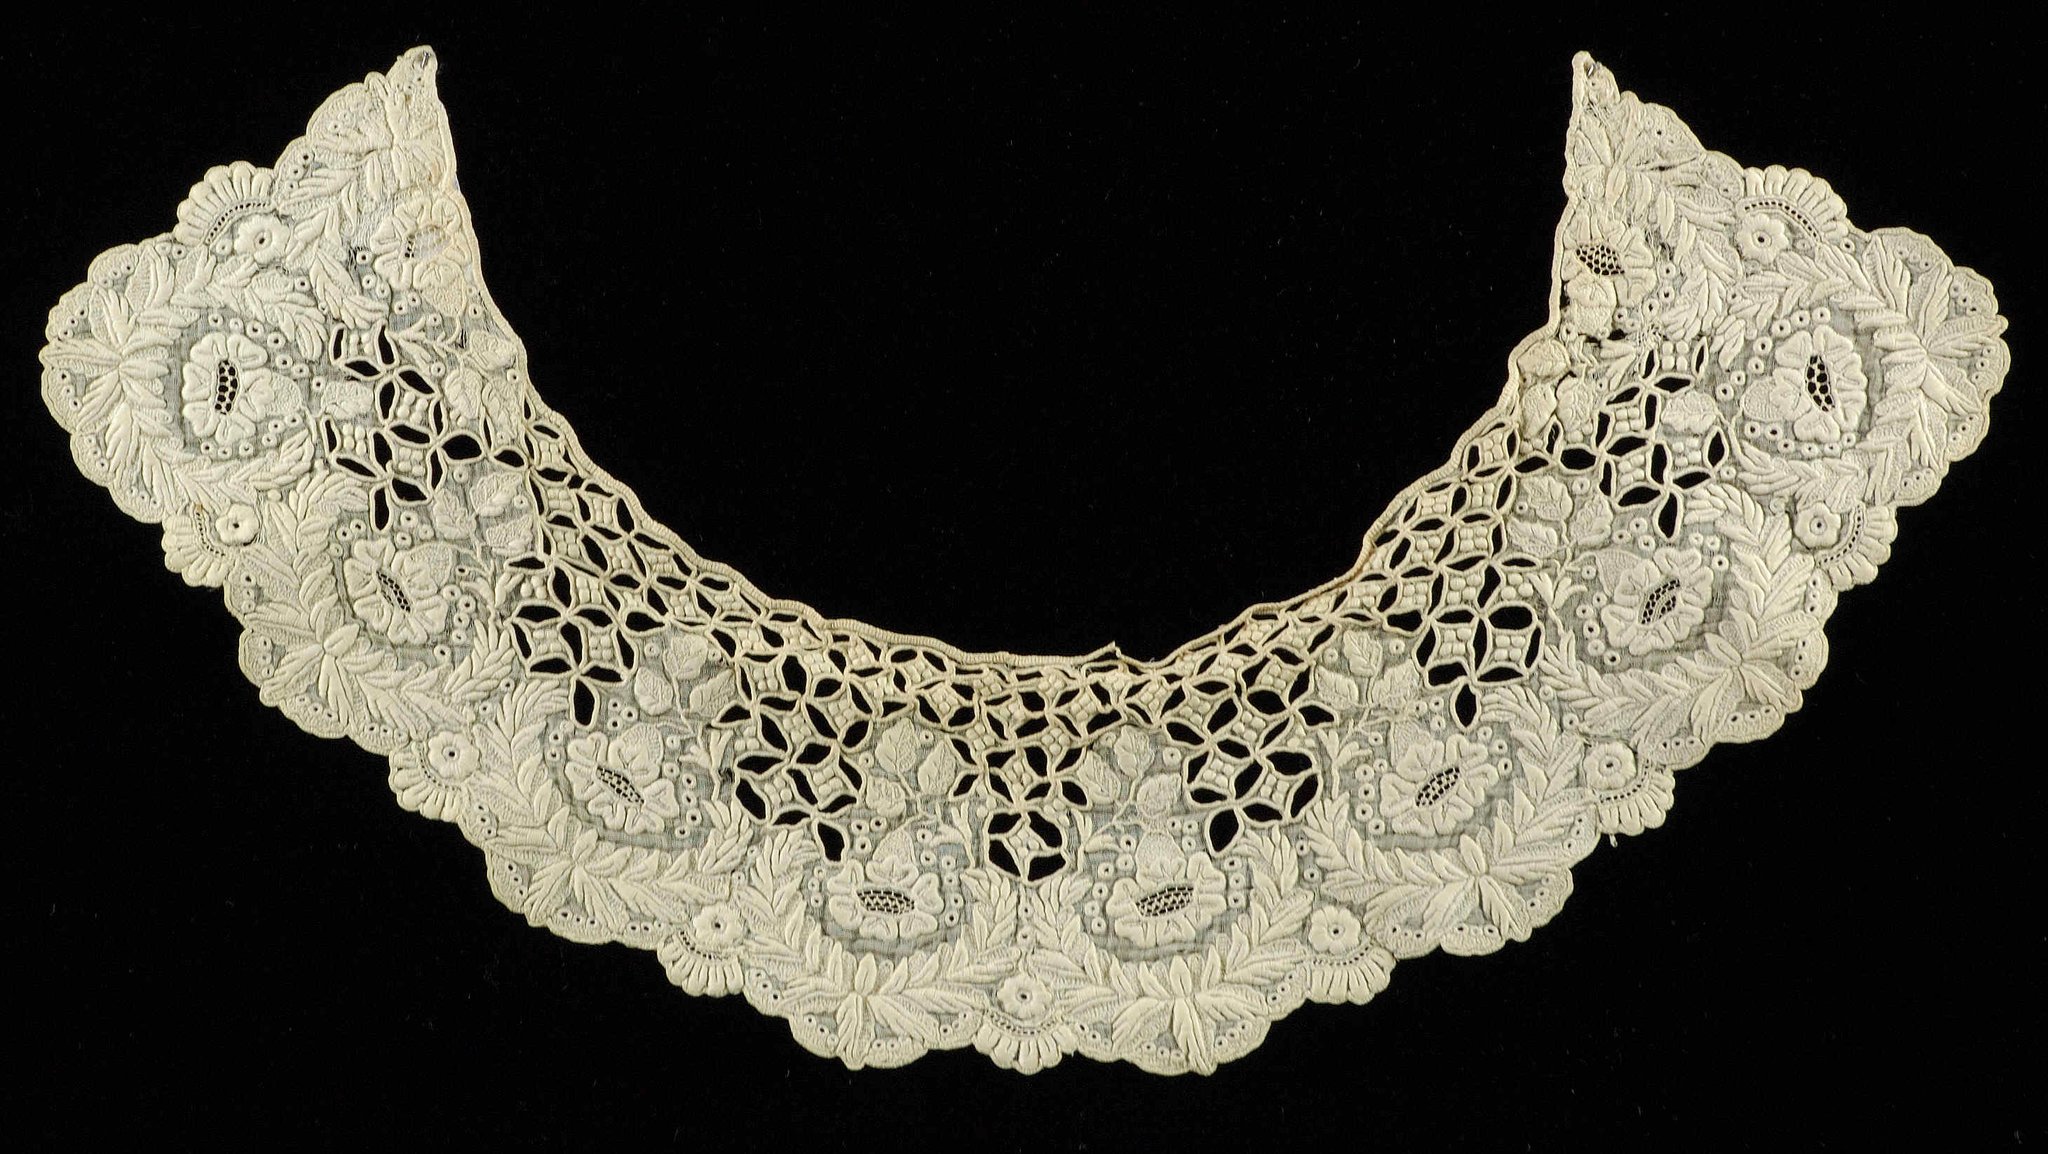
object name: collar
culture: american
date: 1860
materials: cotton